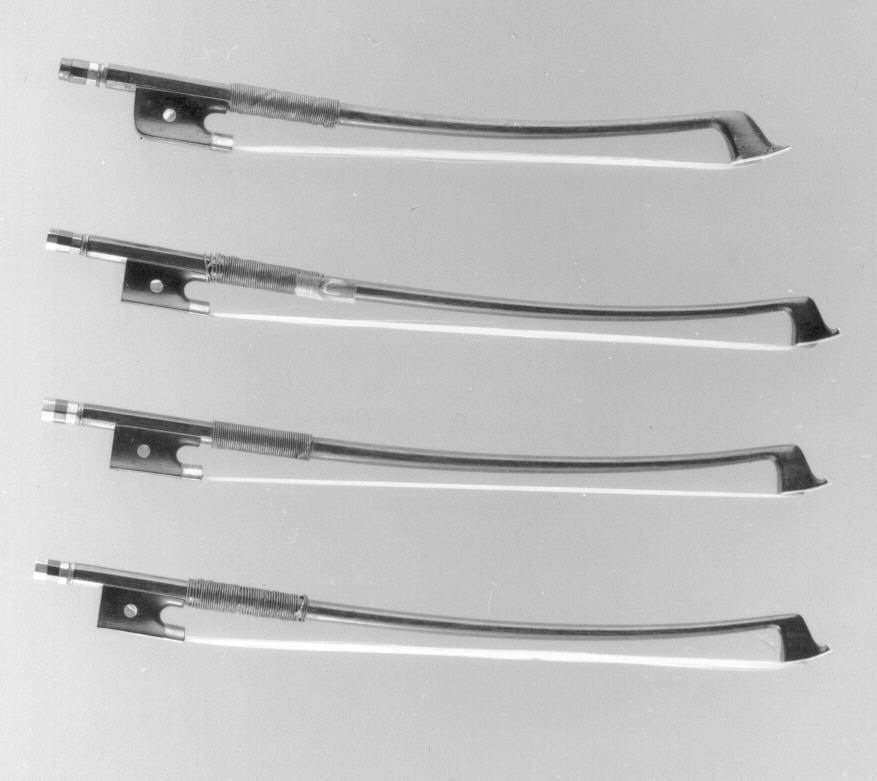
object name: miniature string quartet bow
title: Miniature String Quartet Bows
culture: european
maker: heinrich knopf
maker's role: maker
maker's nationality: german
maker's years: 1839-1875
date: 1880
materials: hair, wood